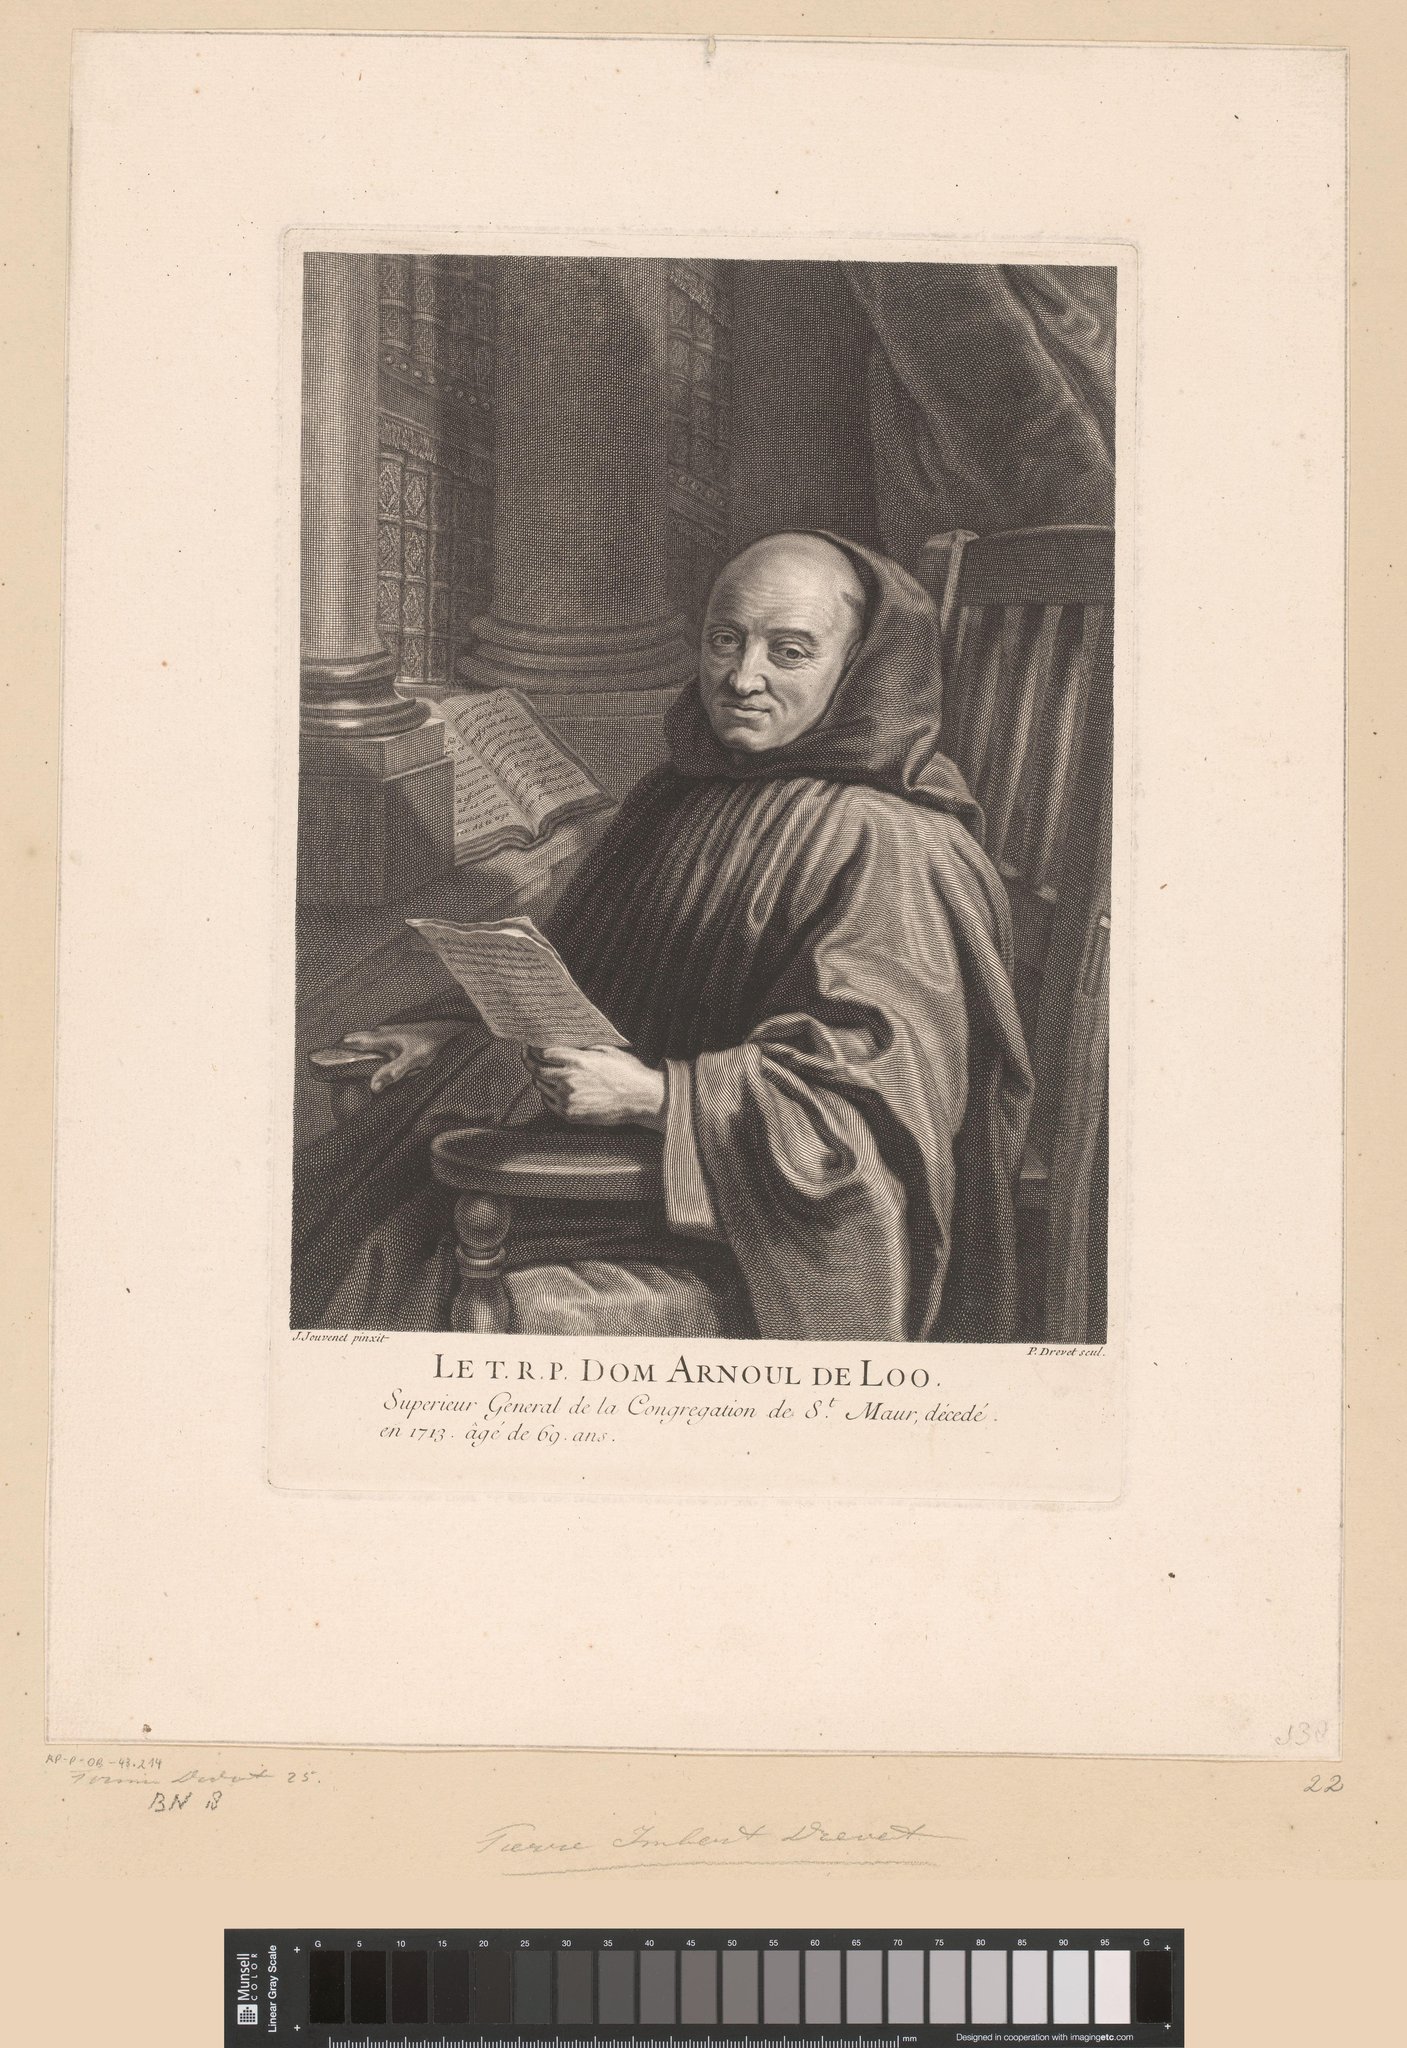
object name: print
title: Portret van Arnoul de Loo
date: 1713-1739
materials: paper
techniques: engraving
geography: france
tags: reading, monastic orders, monastic life: benedictines, historical persons, monk(s), friar(s)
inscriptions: collector's mark: Lugt 240